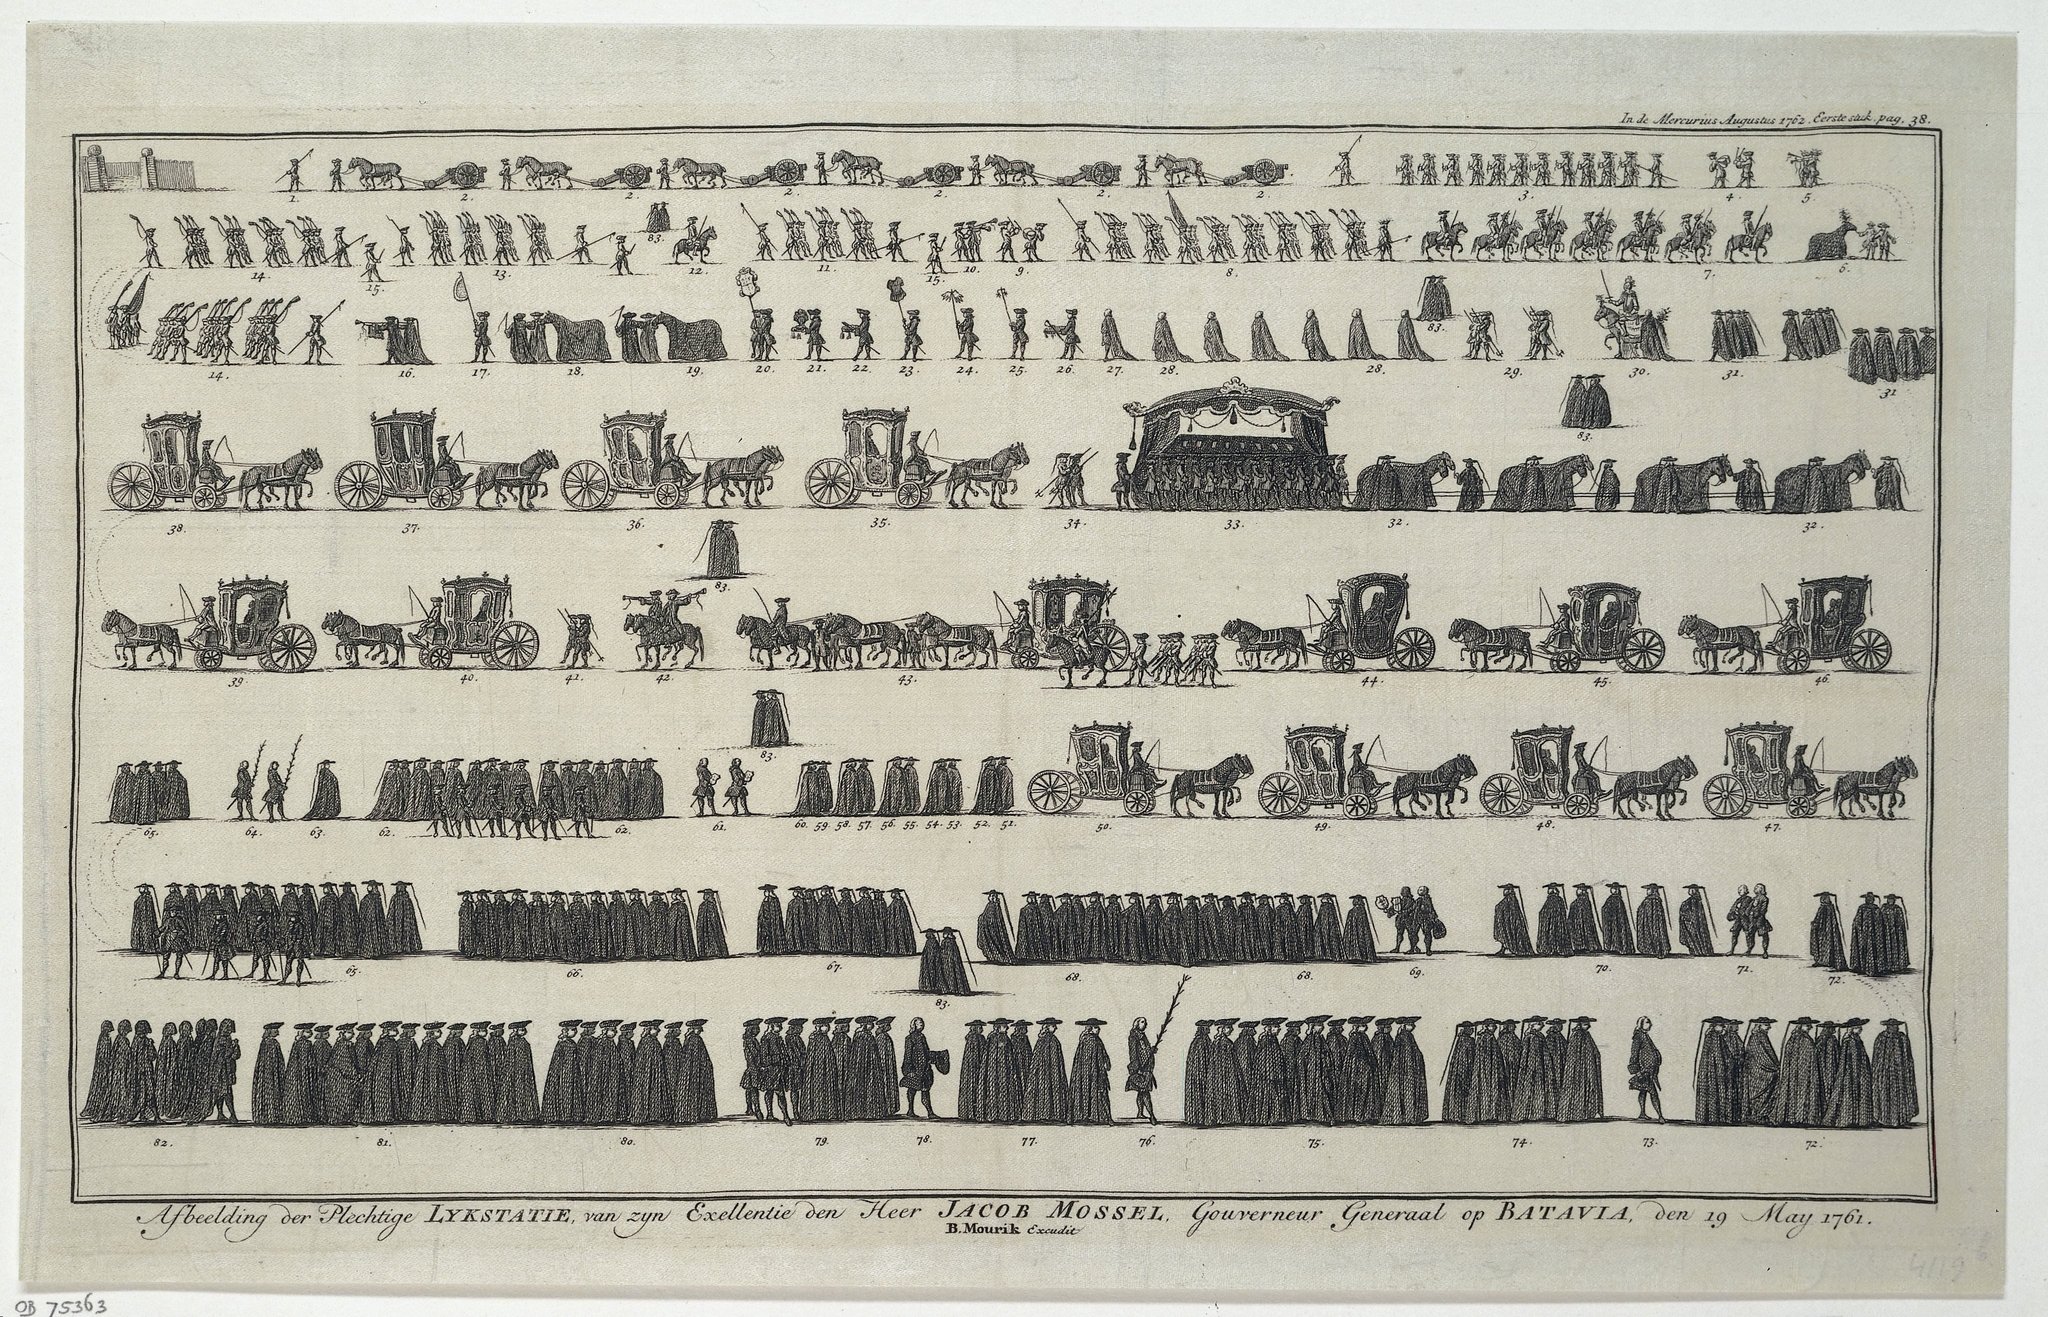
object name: print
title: Afbeelding der Plechtige Lykstatie van zyn Excellentie den Heer Jacob Mossel, Gouverneur Generaal op Batavia, den 19 May 1761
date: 1762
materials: textile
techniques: etching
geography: northern netherlands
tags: enkhuizen, batavia, cortege, funeral procession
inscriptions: collector's mark: Lugt 2228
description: De lijkstatie bij de begrafenis van Jacob Mossel, de Governeur-Generaal te Batavia, 19 mei 1761. De stoet afgebeeld in 8 rijen onder elkaar, details genummerd 1-72. Gemerkt bovenaan: In de Mercurius Augustus 1762. Eerste stuk. pag. 38.